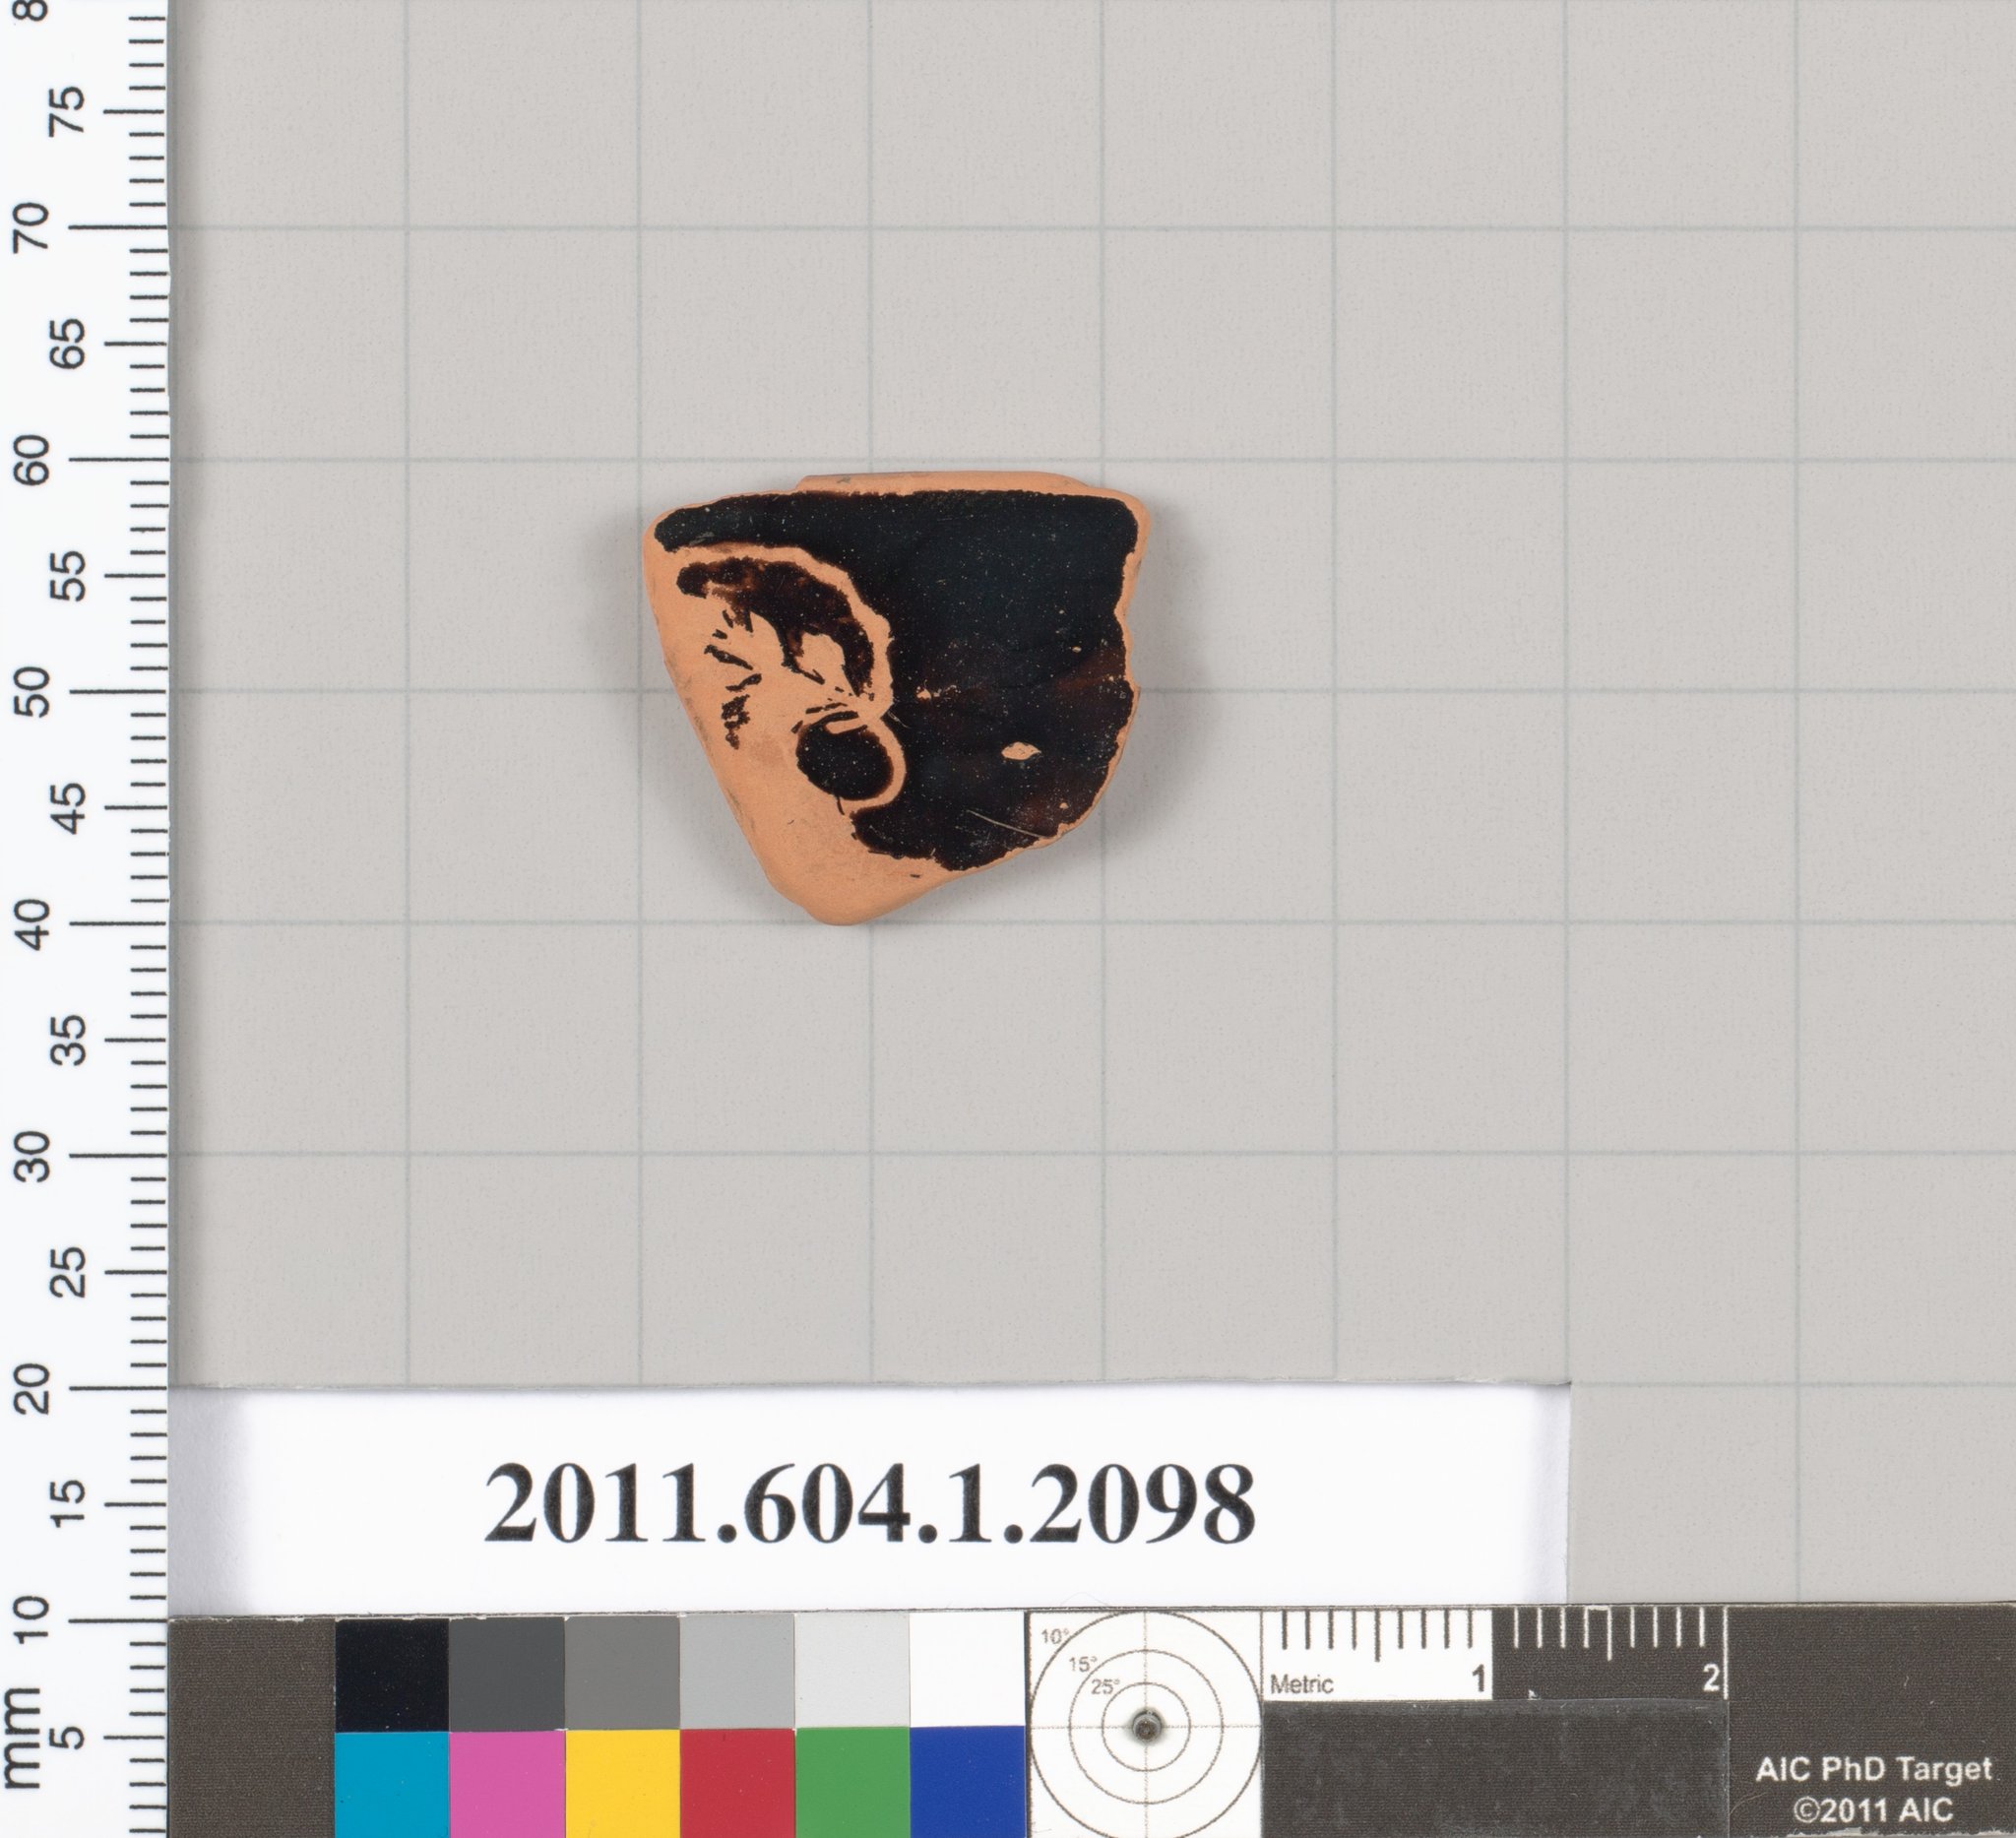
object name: kylix fragment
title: Terracotta rim fragment of a kylix (drinking cup)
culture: greek, attic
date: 467-435 BCE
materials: terracotta